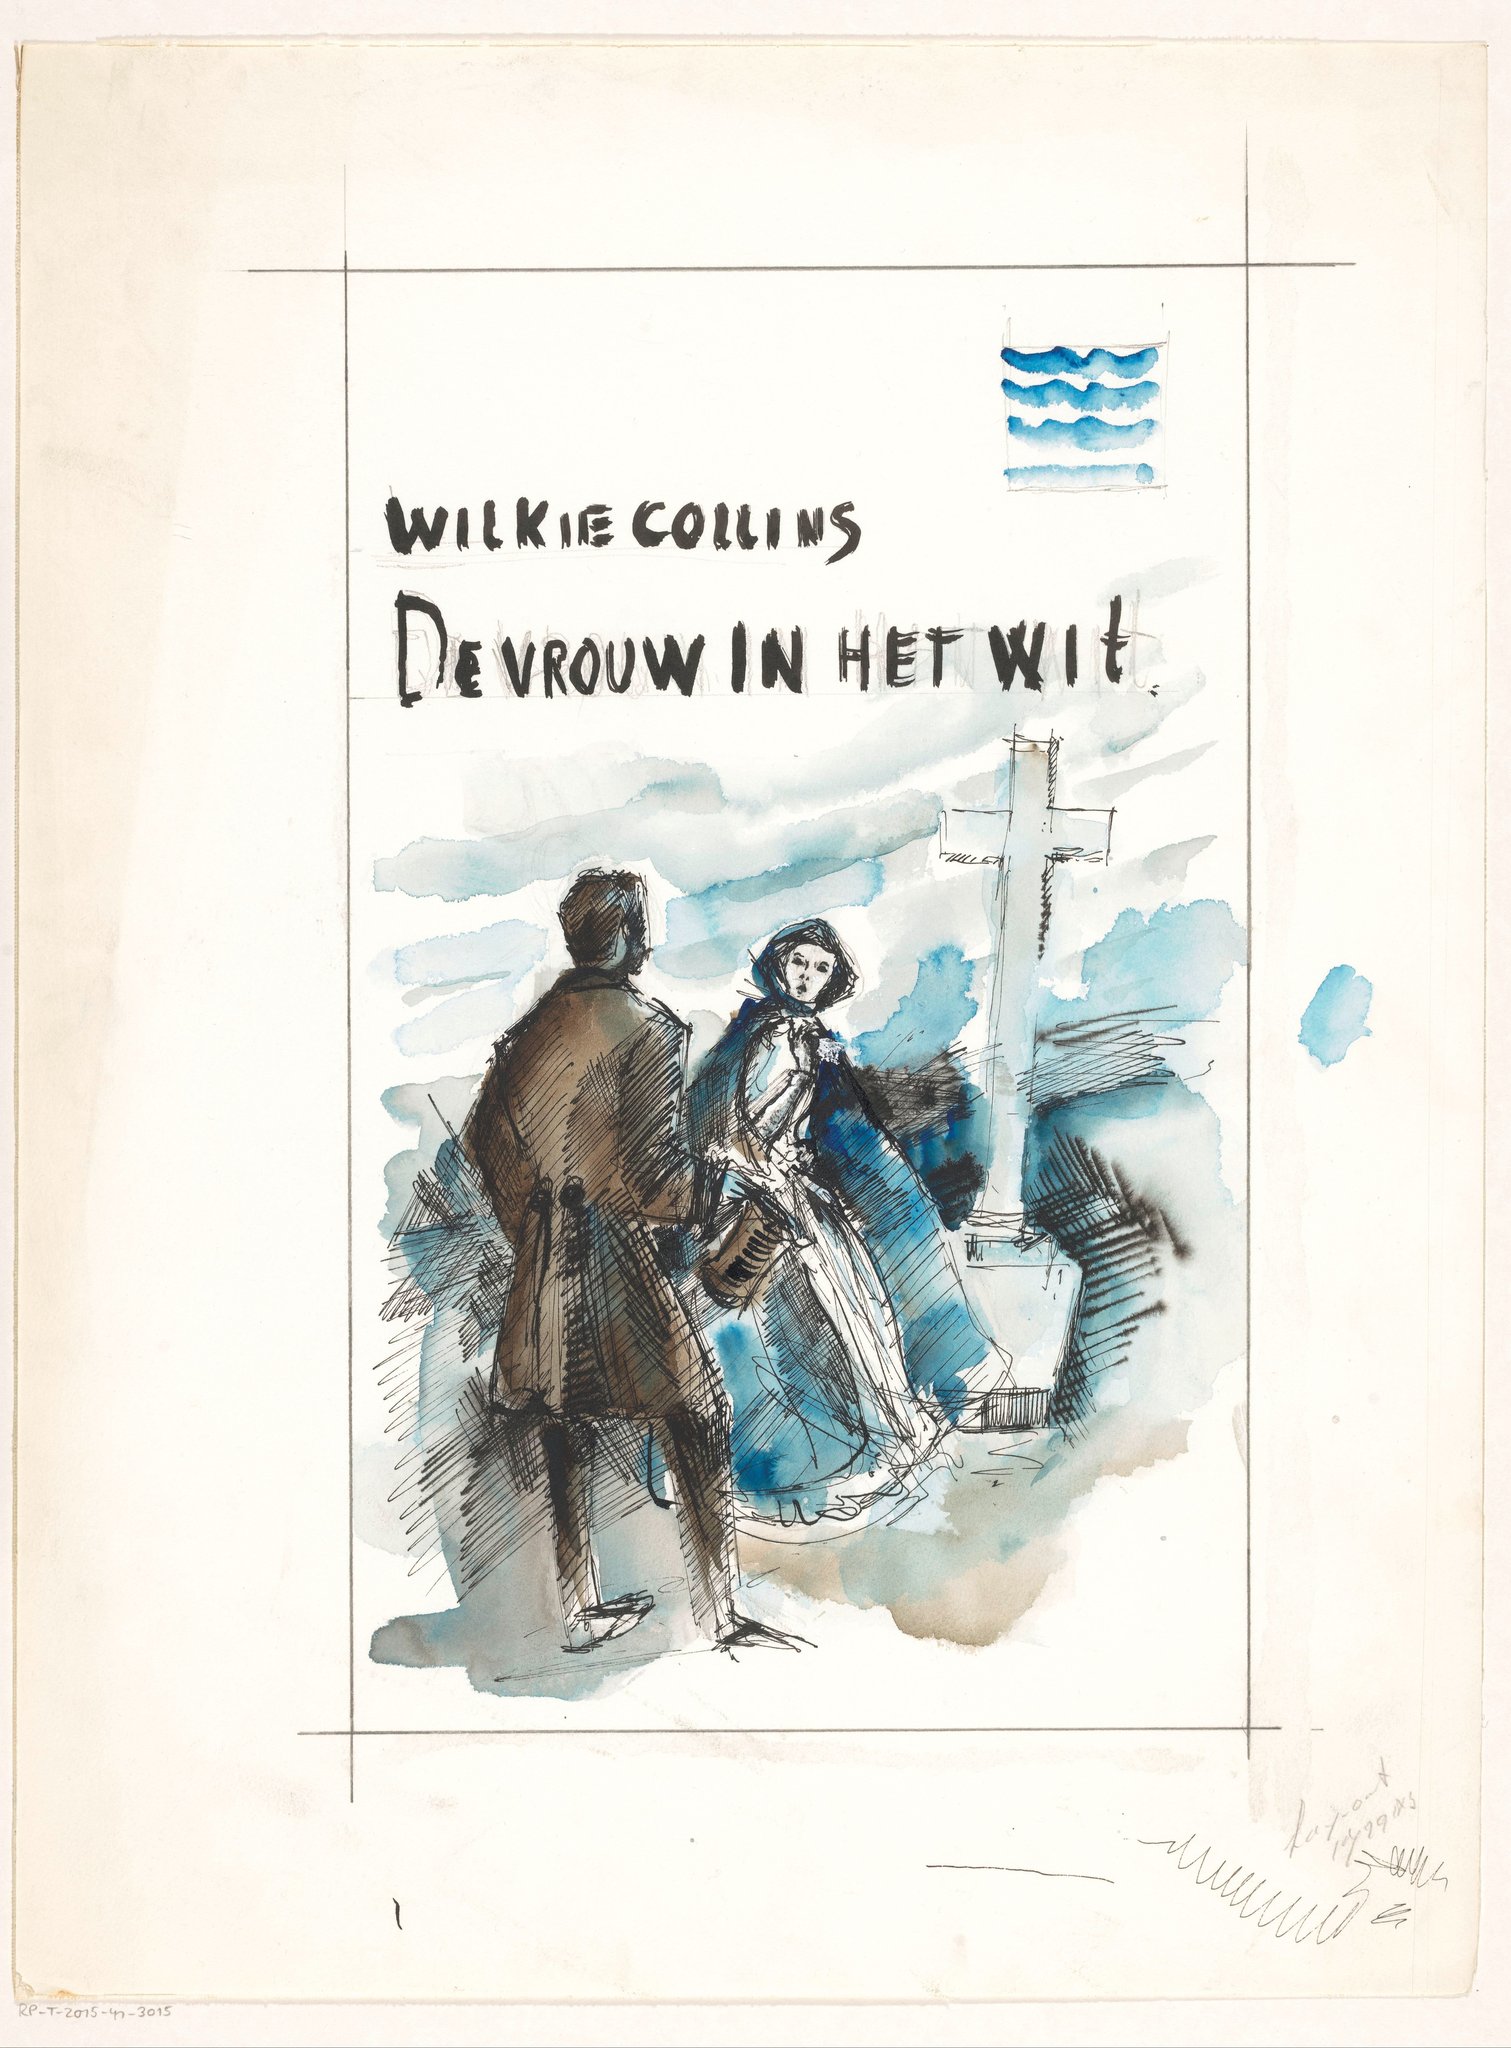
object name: study for binding design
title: Bandontwerp voor: Wilkie Collins, De vrouw in het wit (The woman in white), 1961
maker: Anonymous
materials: paint, ink, paper, pencil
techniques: brush, pen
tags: low hill country, churchyard, cemetery, meeting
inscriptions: collector's mark: Lugt 2228a, :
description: Een man en vrouw ontmoeten elkaar op een begraafplaats bij een marmeren kruis. In de achtergrond een heuvellandschap.